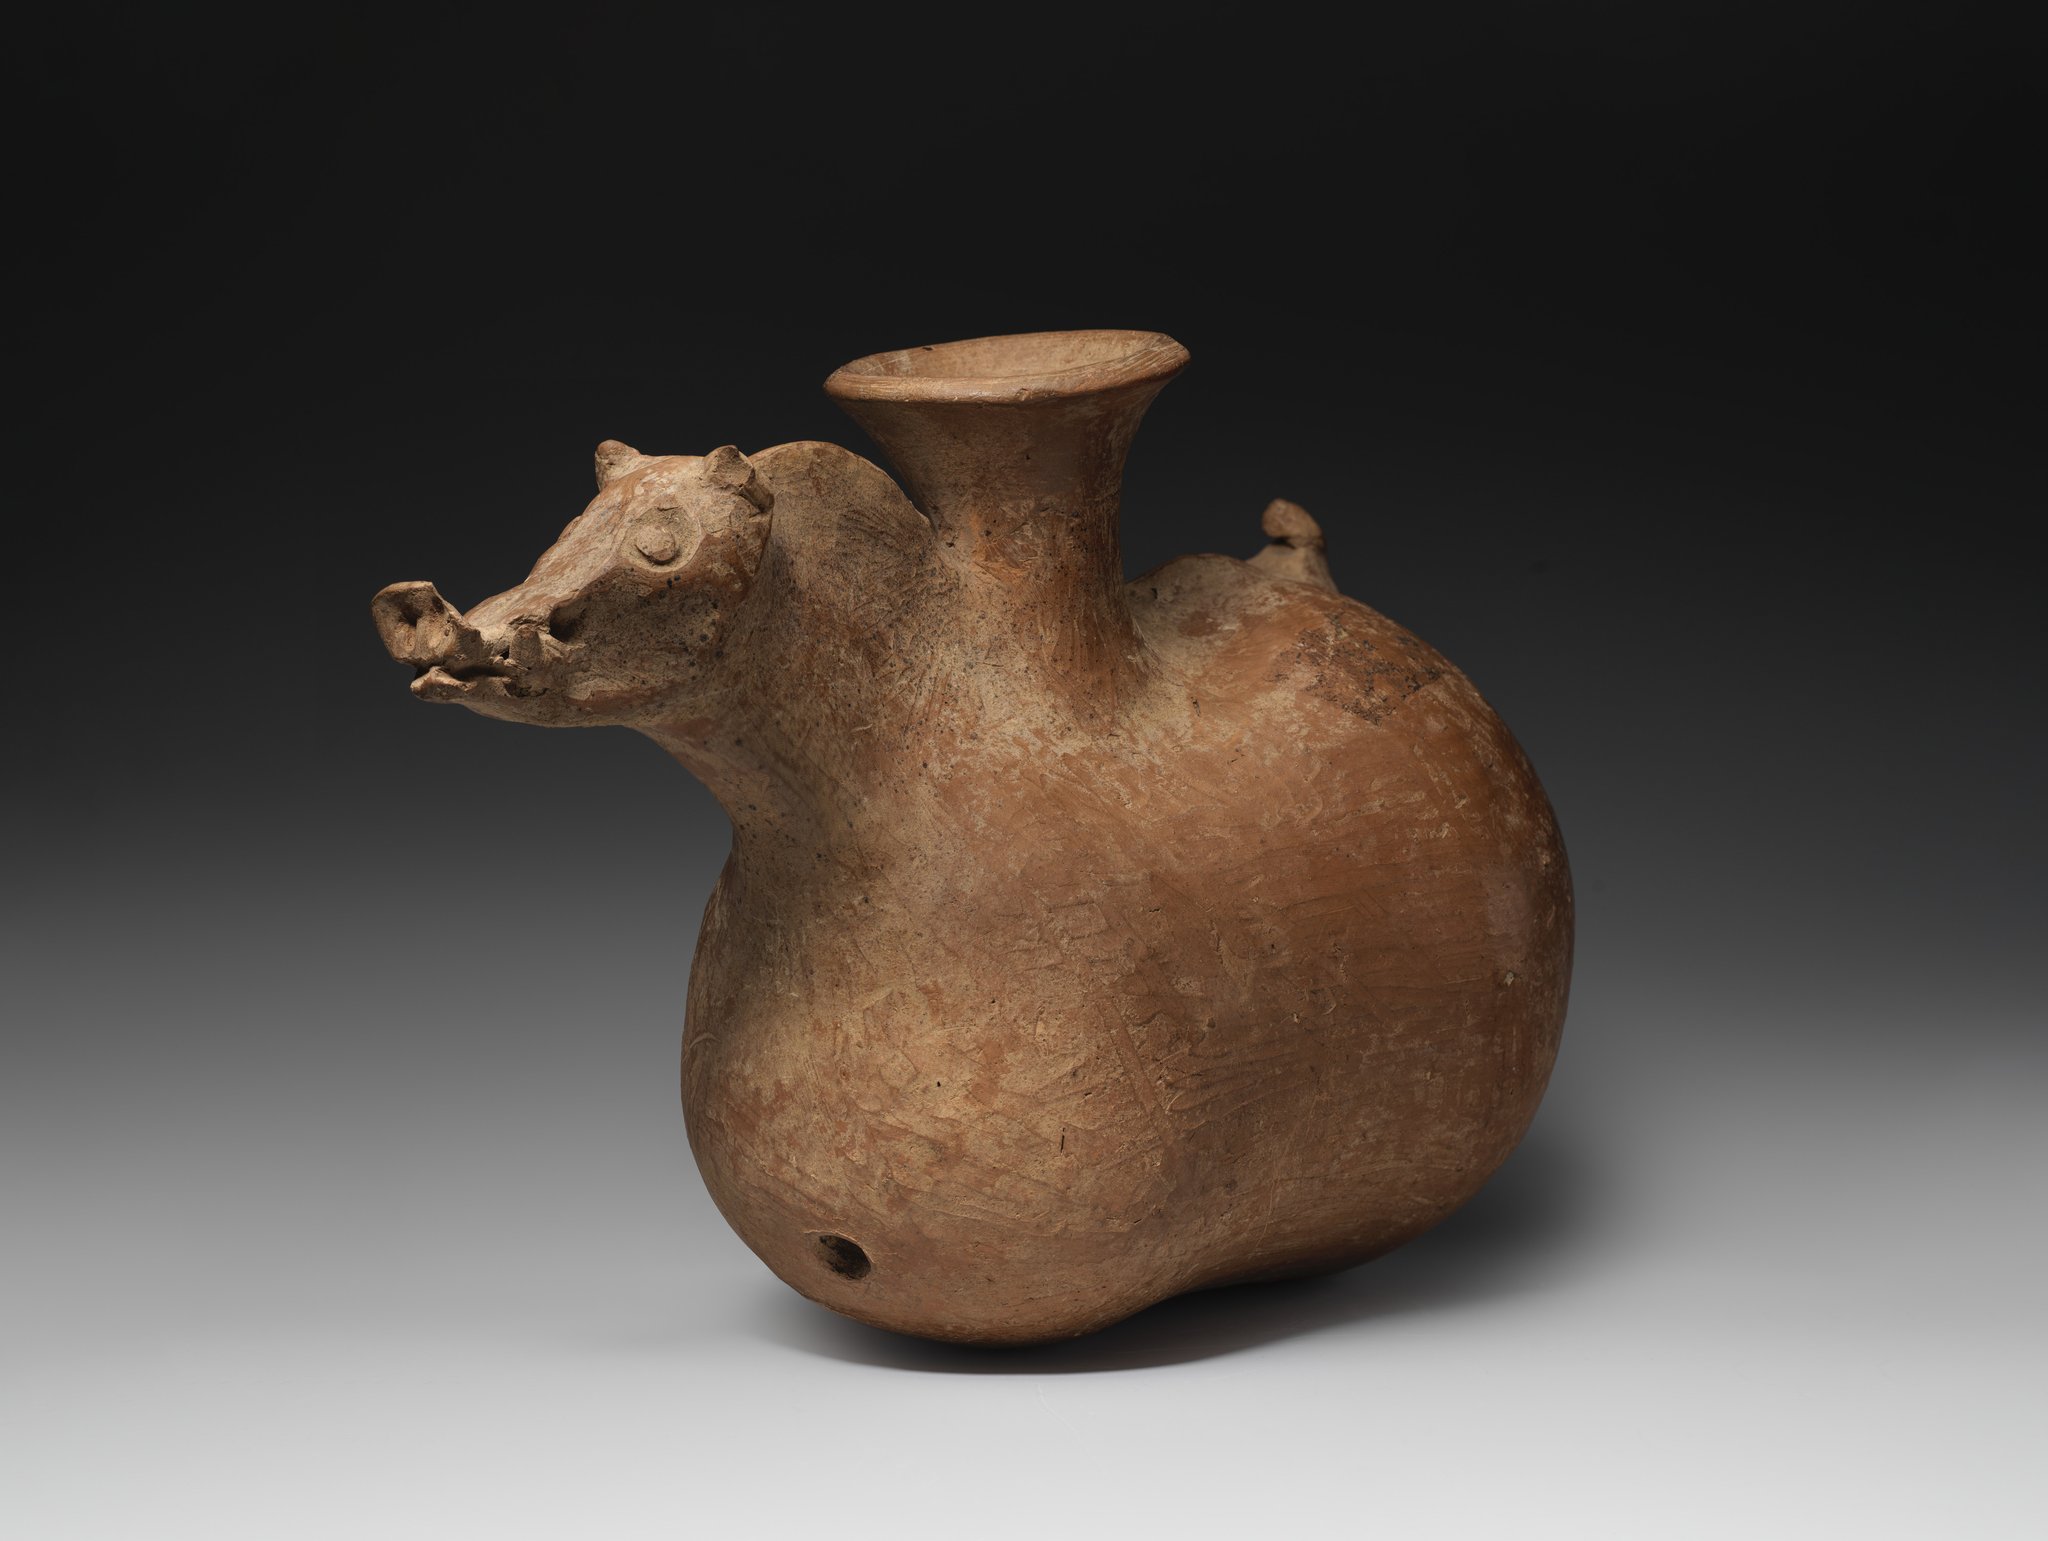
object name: rhyton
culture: iranian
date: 1000-1 BCE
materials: ceramic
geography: northwestern iran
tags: boars